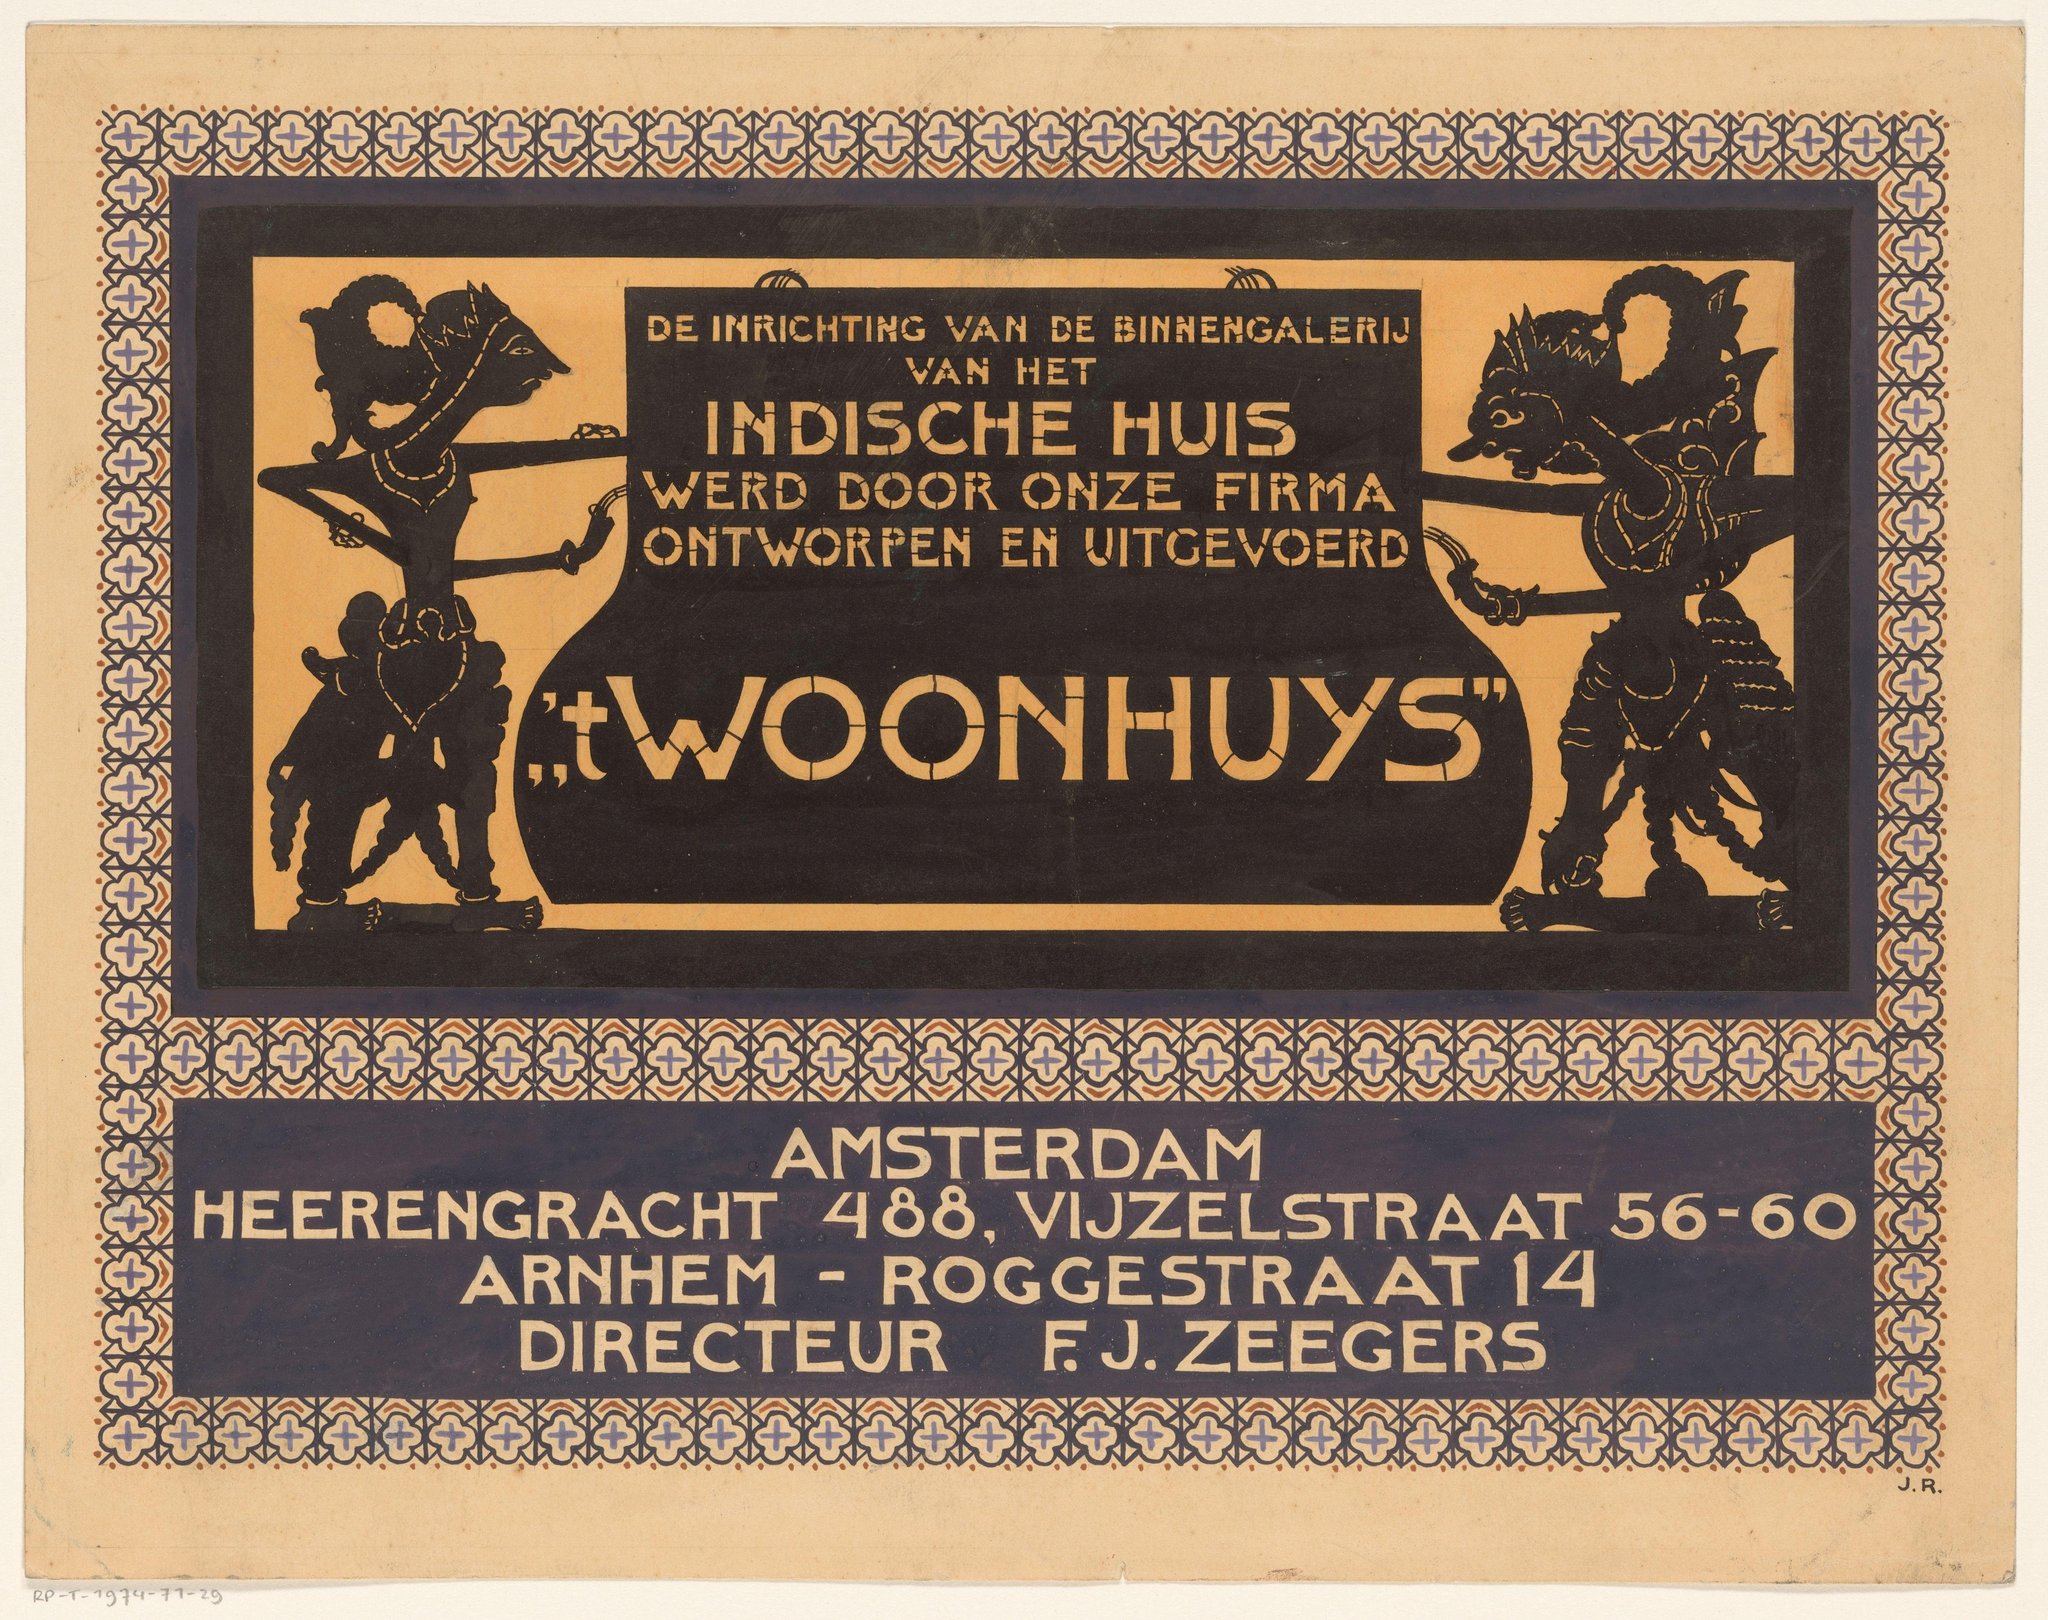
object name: drawing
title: Ontwerp voor een affiche met wajangpoppen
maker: Anonymous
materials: ink, paint, paper, pencil, watercolor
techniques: brush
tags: dolls for adults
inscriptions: collector's mark: ‘R:MVS’, monogram: ‘J.R.’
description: Reclame-uiting voor meubelfabriek 't Woonhuys te Amsterdam met twee tekstvakken op een decoratief patroon. Bovenaan de tekst dat de firma de inrichting van het Indisch Huis ontwierp en verzorgde met aan weerszijden van de tekst een wajangpop. Onderaan de vermelding van het adres en de directeur van de firma.